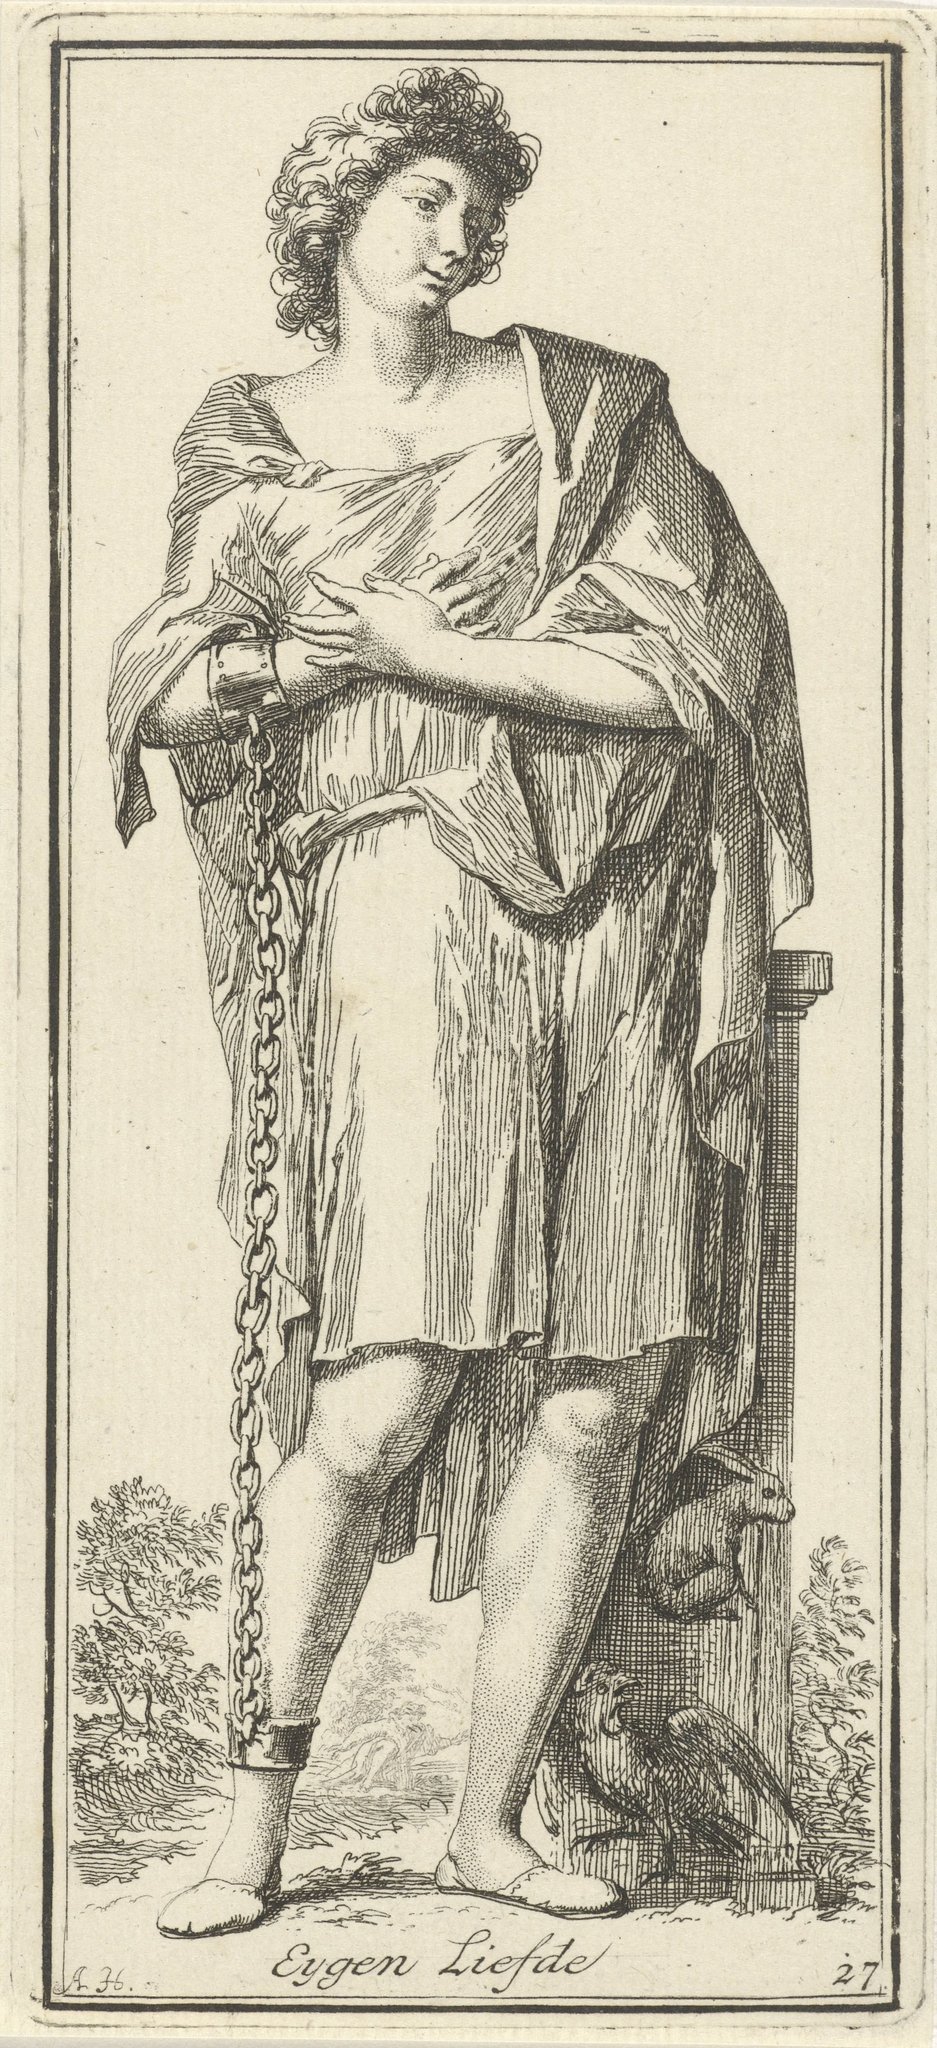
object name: print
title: Personificatie van de zelfwaardering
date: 1710-1719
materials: paper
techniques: engraving, etching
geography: amsterdam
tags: love personified, tools, aids, implements ~ crafts and industries: chain, acts of the will (opposing concepts)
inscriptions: collector's mark: Lugt 2228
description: Een figuur als personificatie van eigenwaarde of zelfwaardering, wiens arm aan eigen voet is geketend en de handen op de borst rusten. Links een haan en een konijn. Prent uit een serie van 41 zinnebeelden.